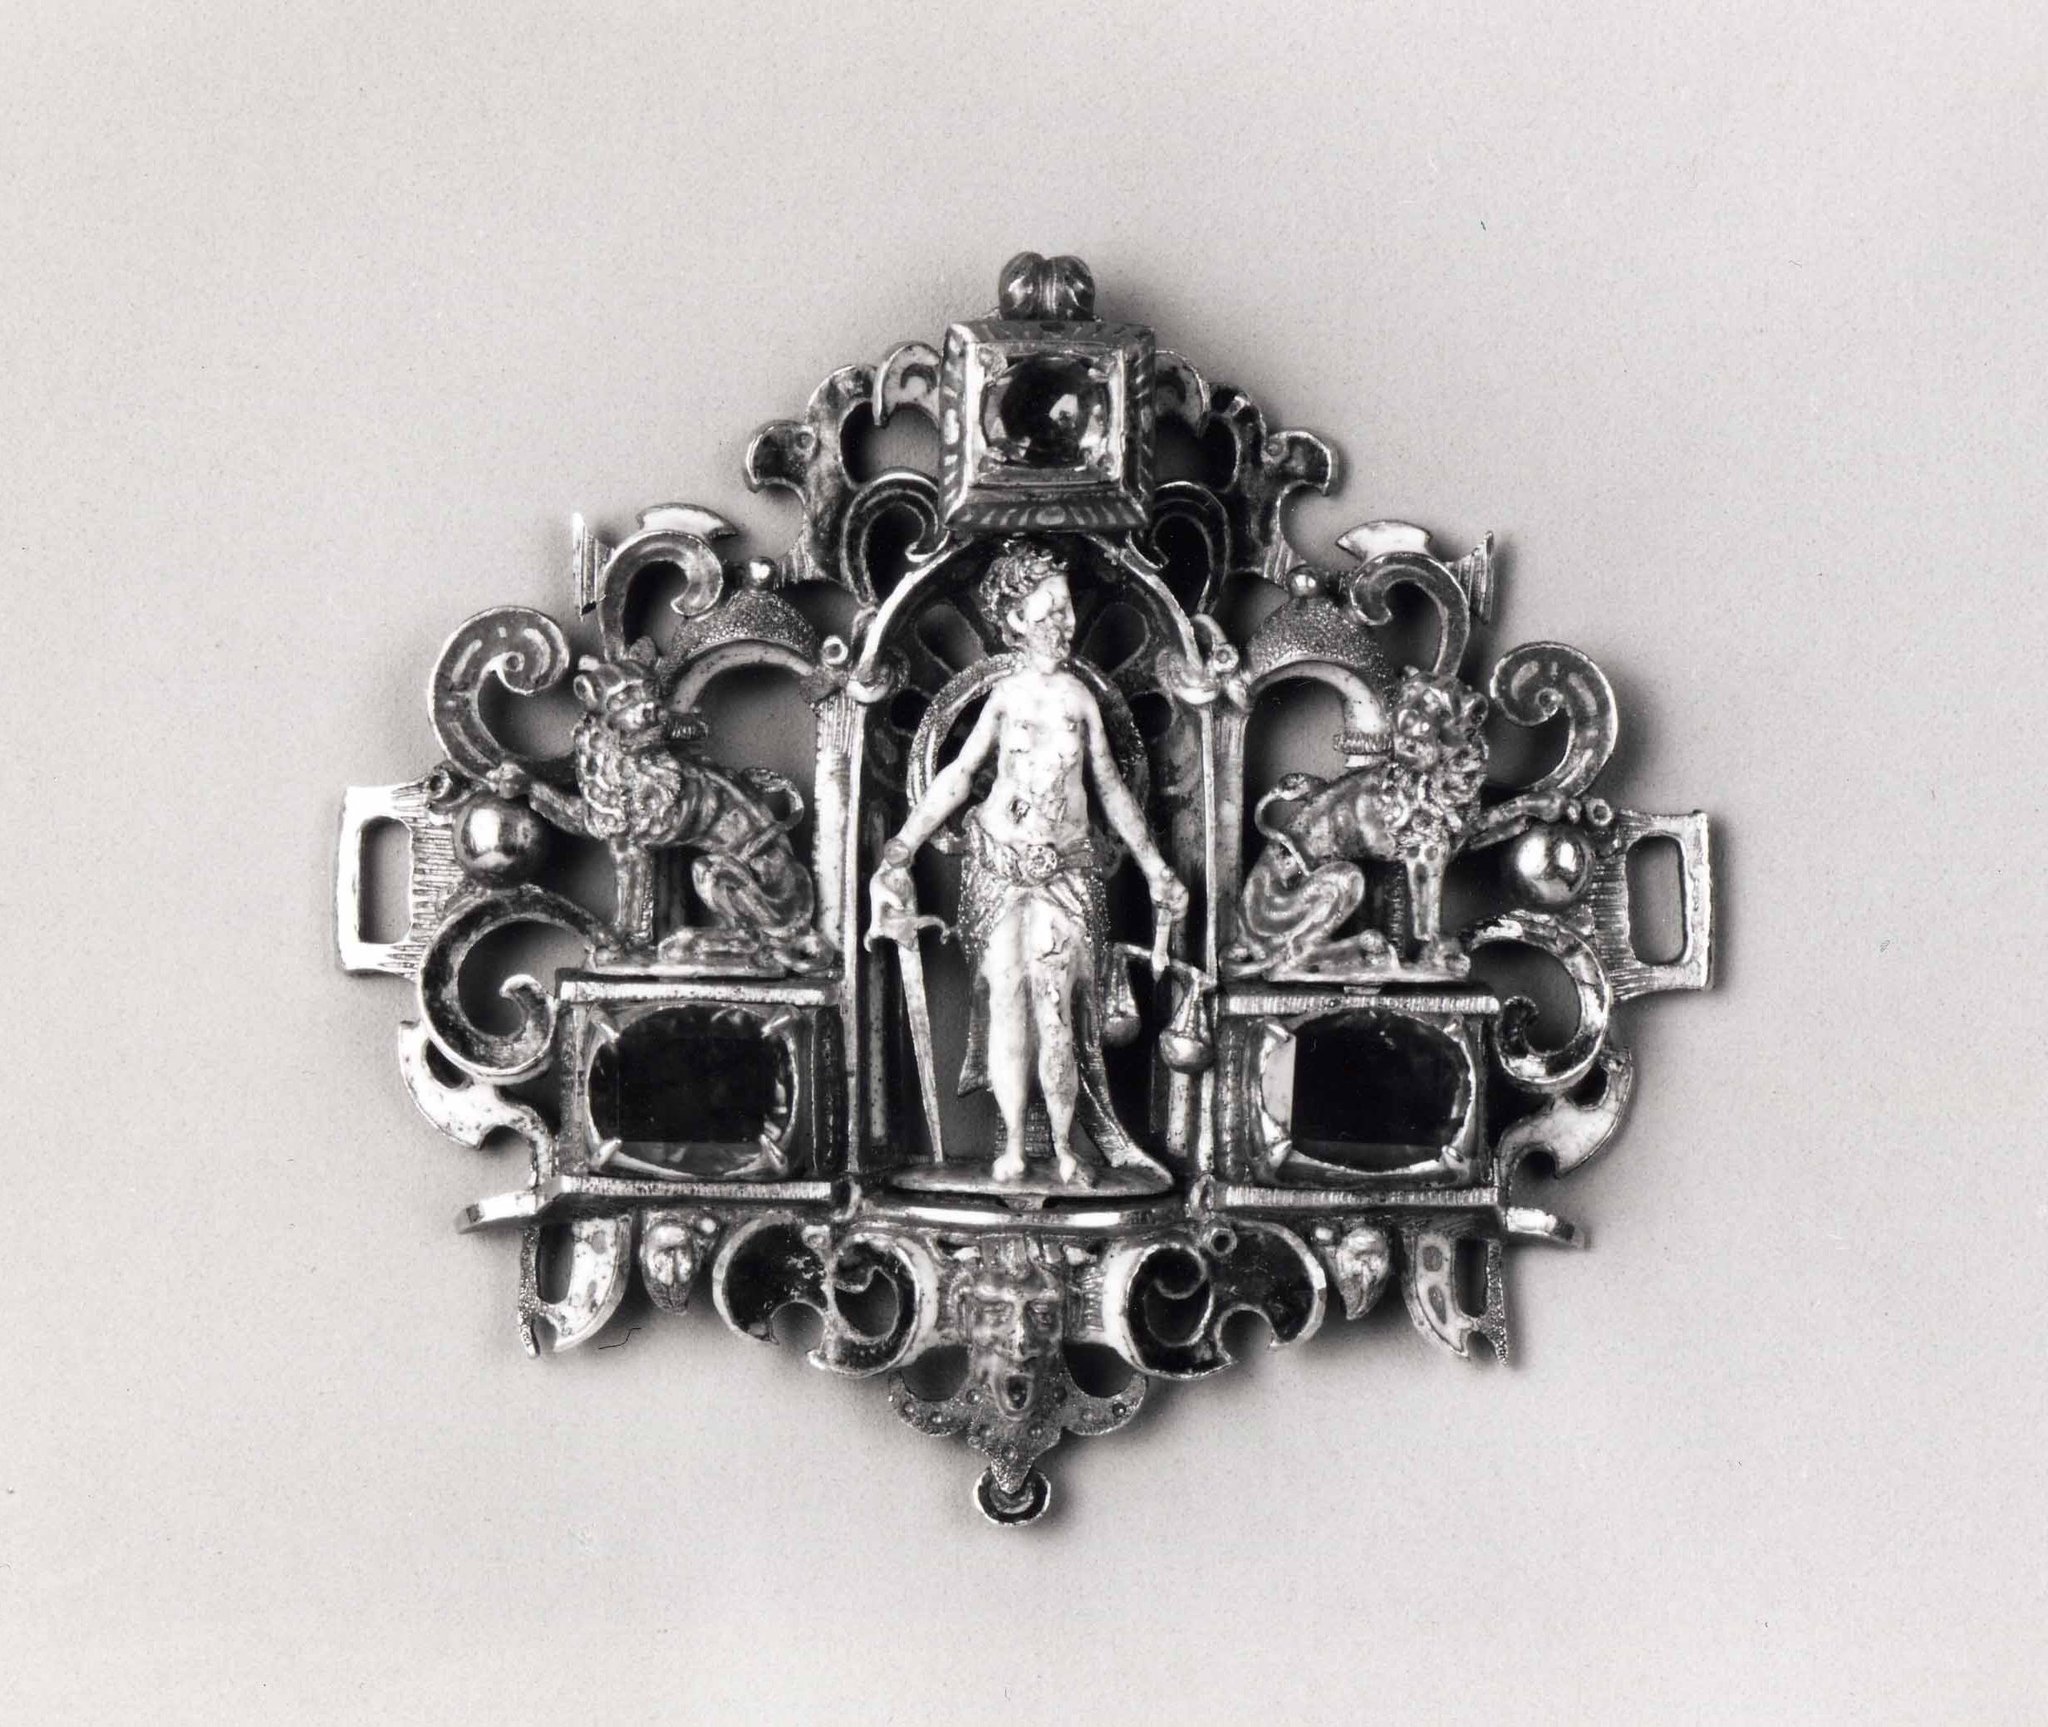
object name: link ornament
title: Link from a belt with Figure of Justice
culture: german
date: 1567-1600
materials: enamel, gold, gemstone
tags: female nudes,lions